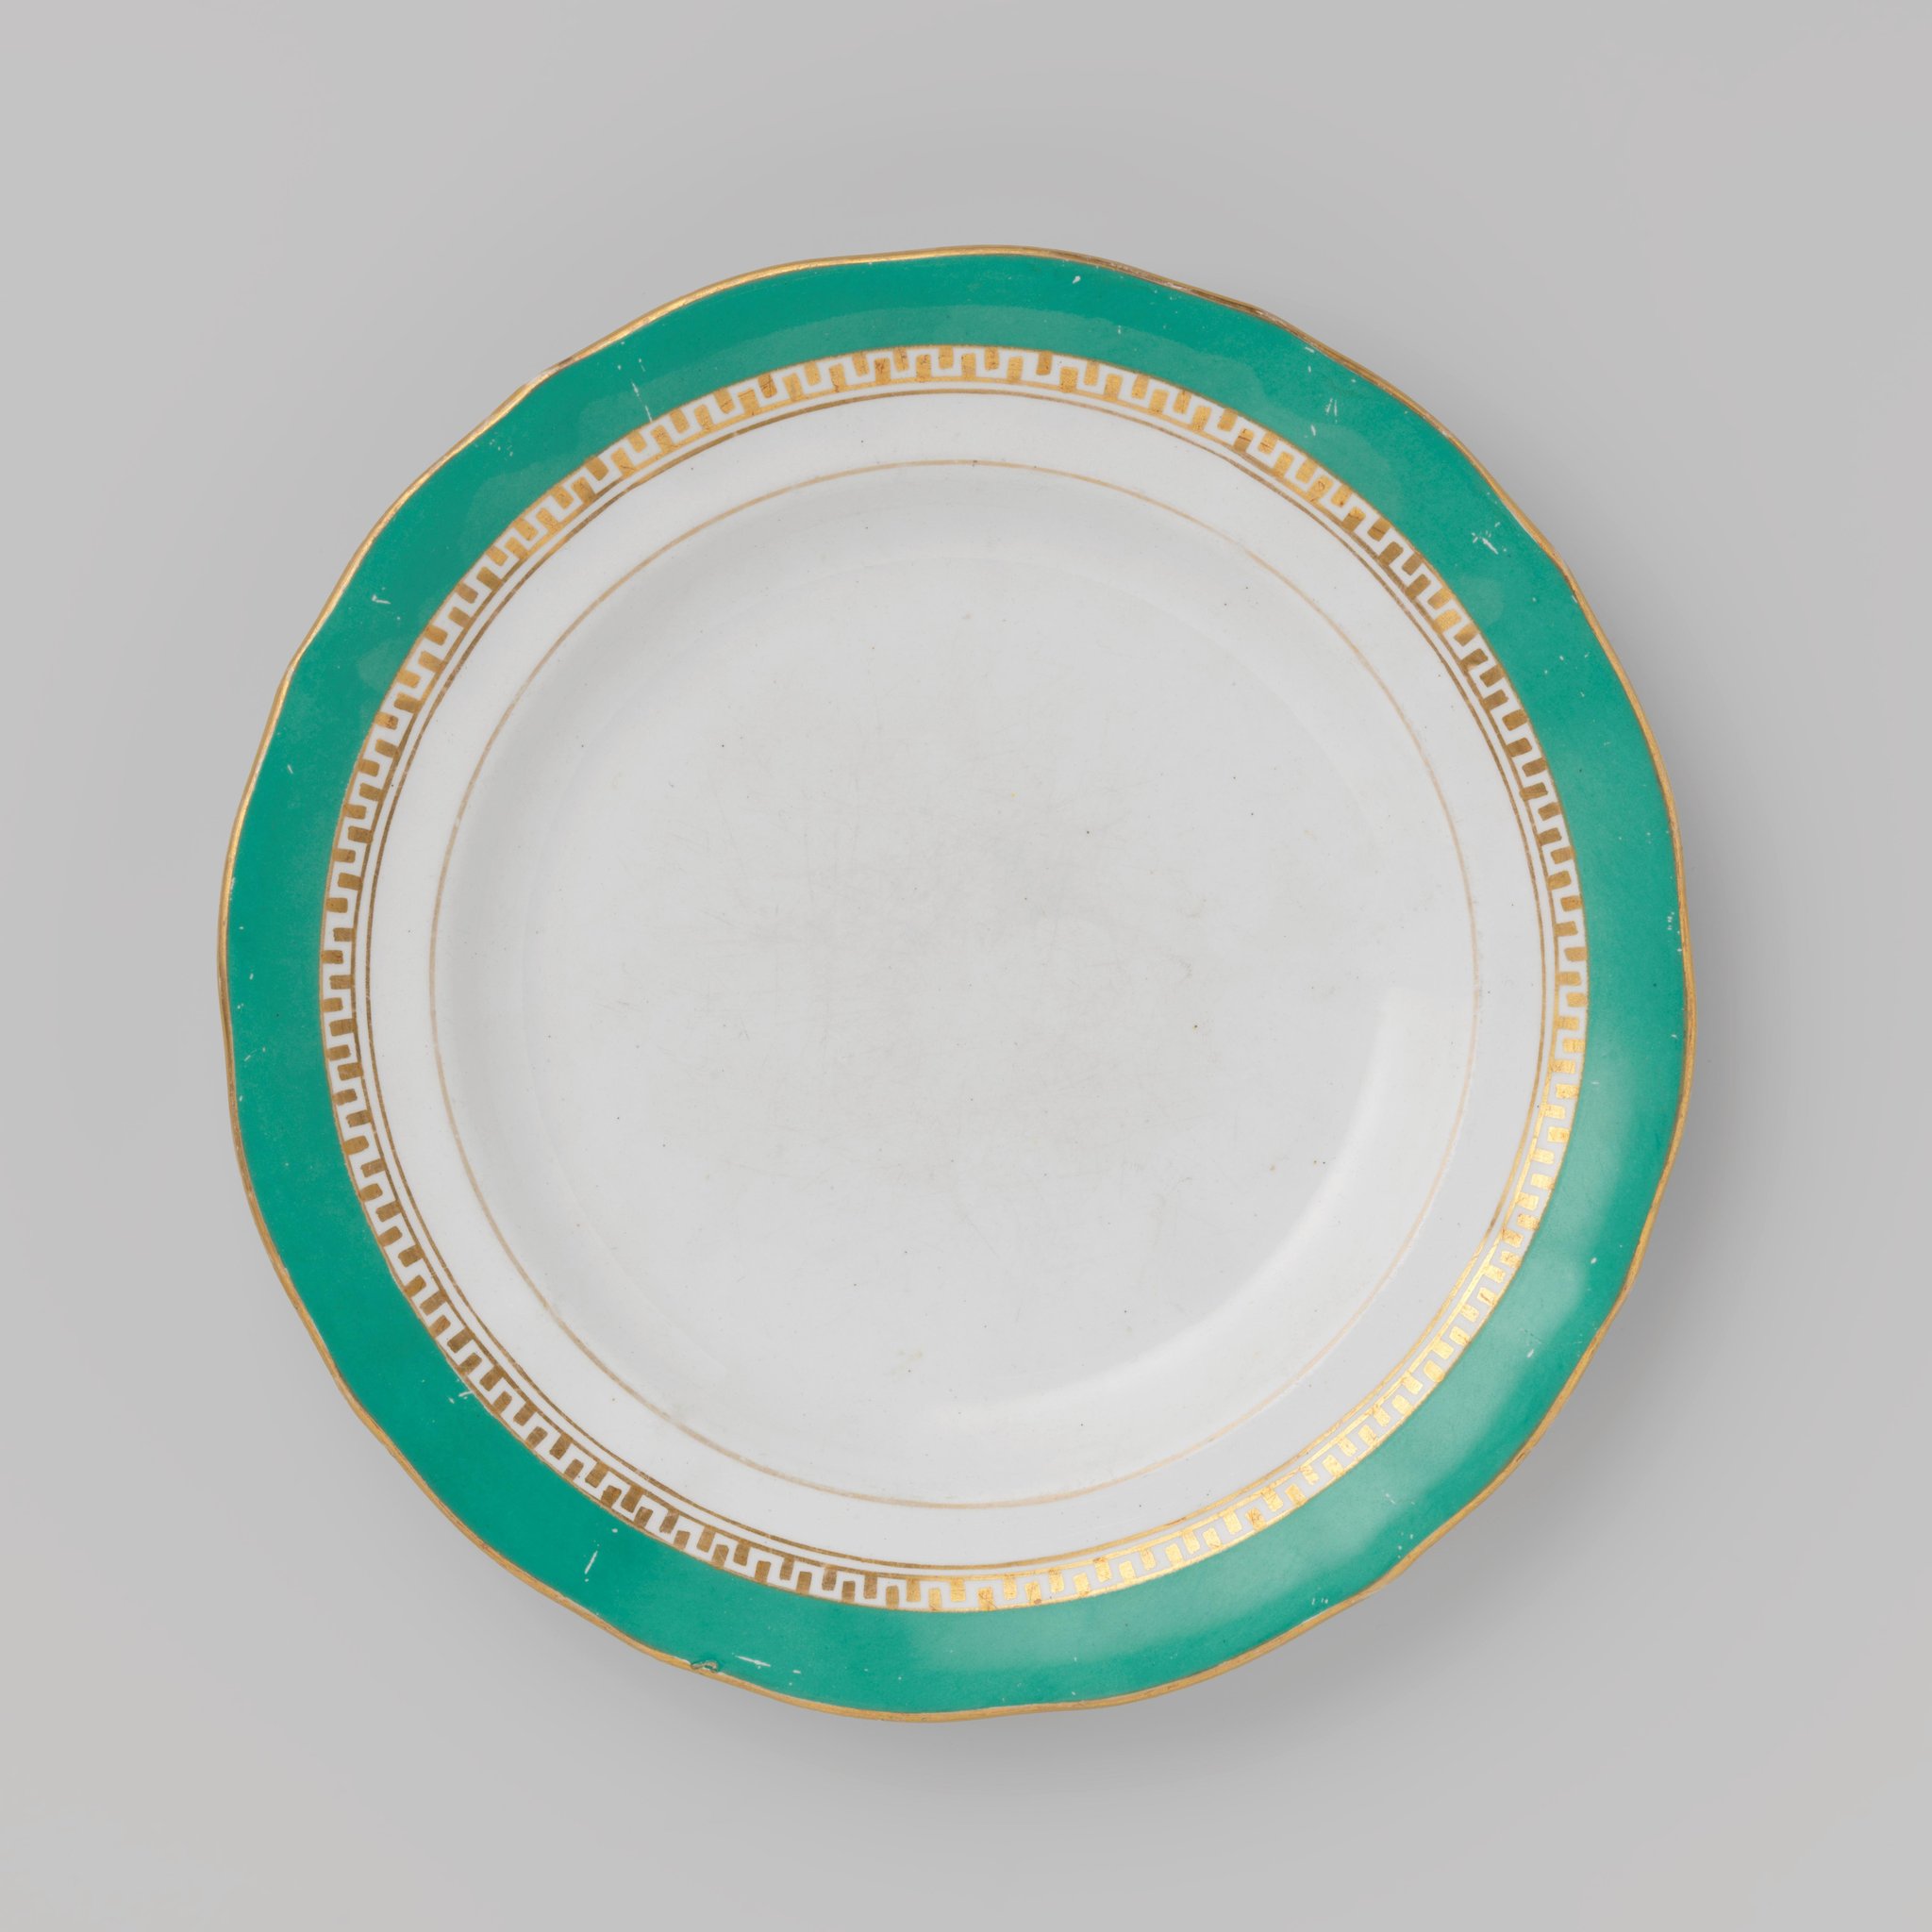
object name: plate dish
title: Bord met groene rand en gouden Griekse band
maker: petrus regout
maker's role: plateelbakker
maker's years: 1801-1879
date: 1865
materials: earthenware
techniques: transfer decoration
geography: maastricht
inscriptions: check stamp: ‘P. REGOUT // MAASTRICHT // 17X’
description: Bord van aardewerk, geschulpt, met groene rand en gouden Griekse band.